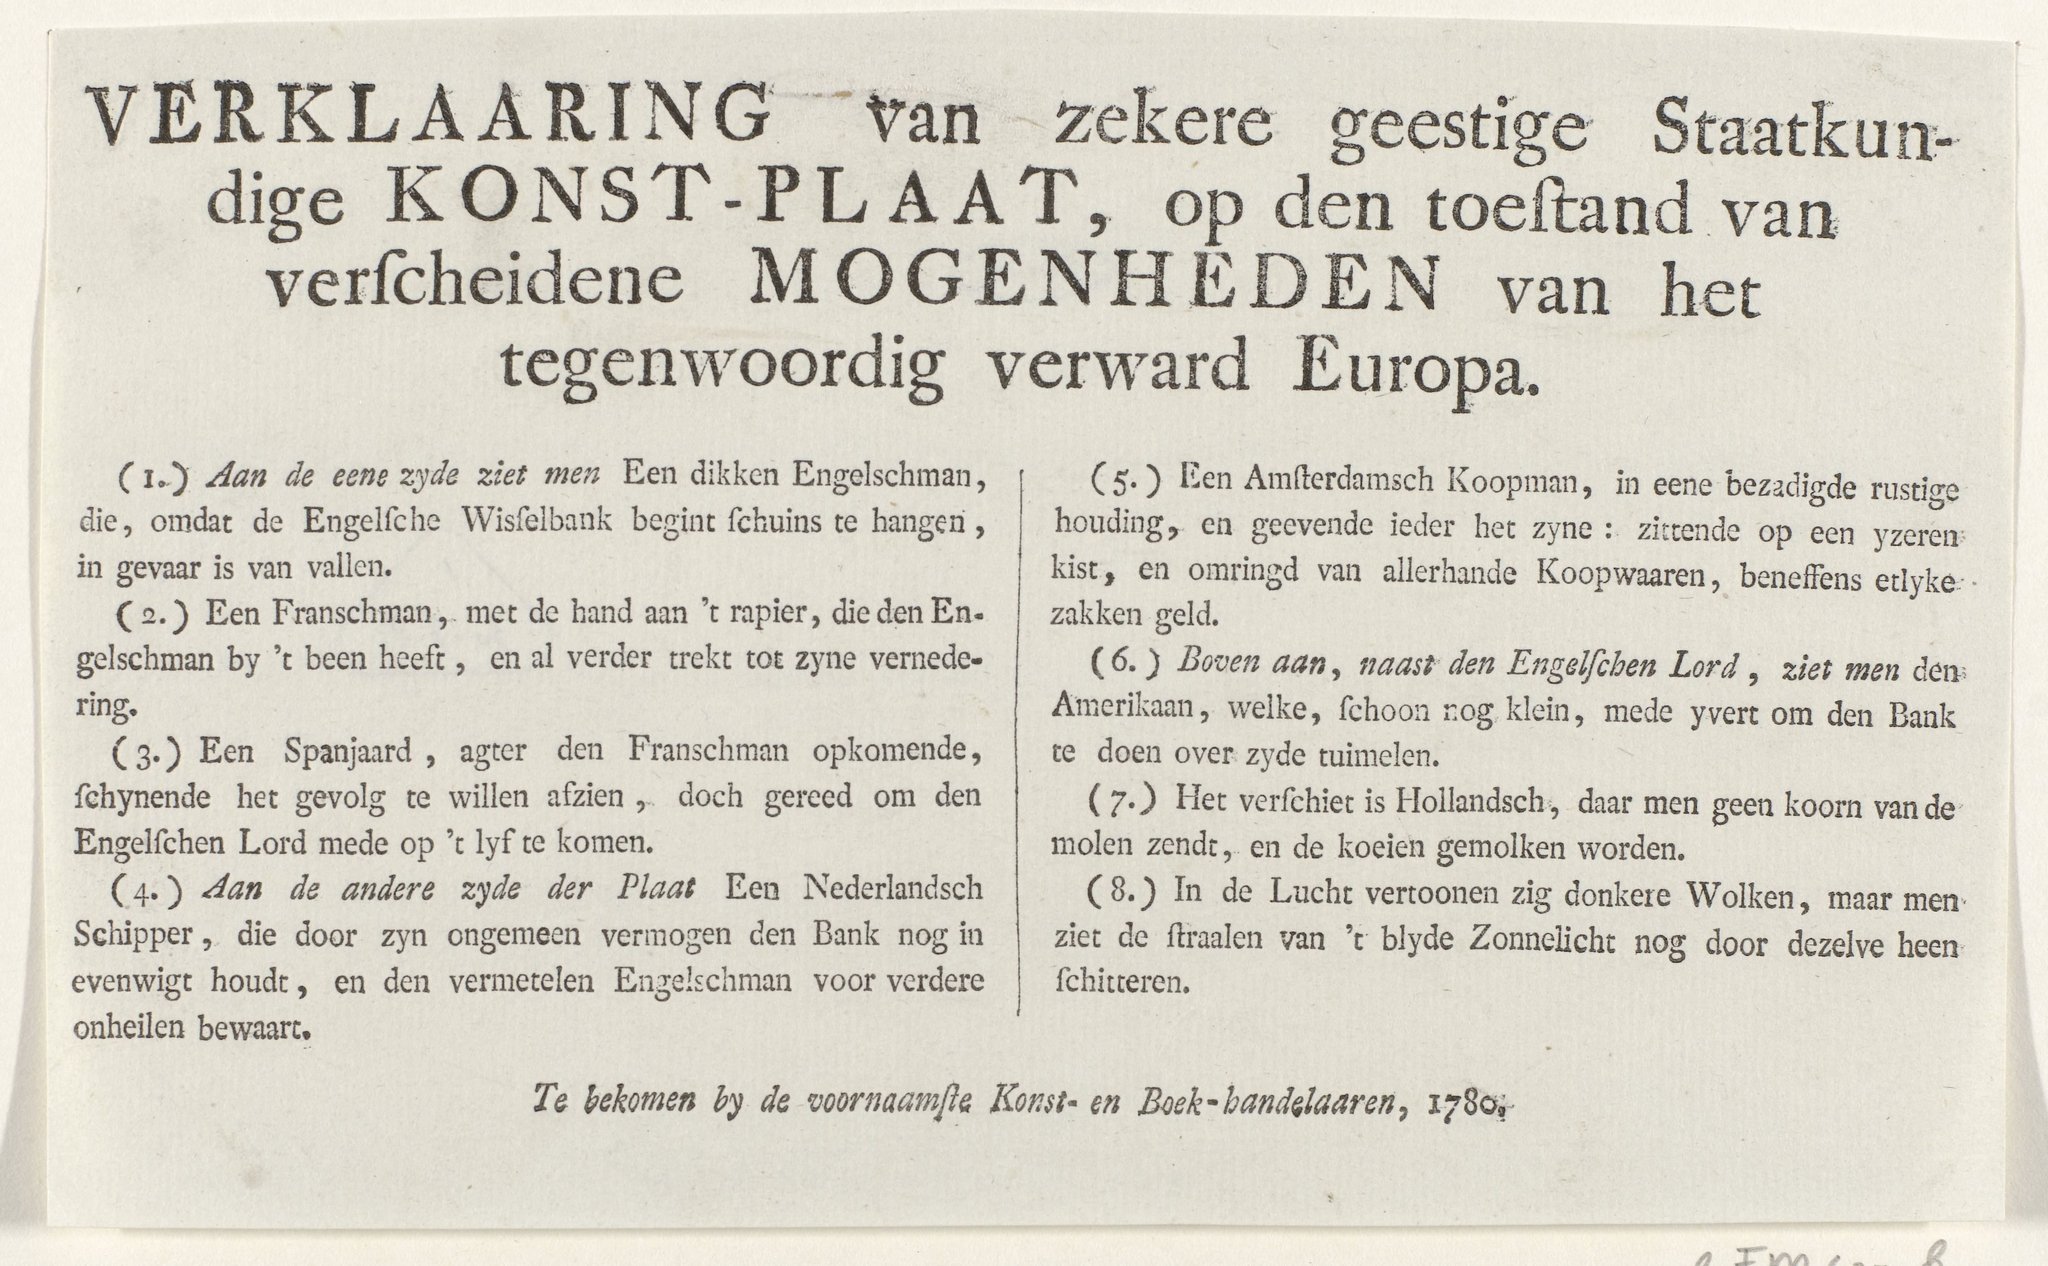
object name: cartoon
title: Verklaaring van zekere geestige Staatkundige Konst-Plaat, op den toestand van verscheidene Mogendheden van het tegenwoordig verward Europa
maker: Anonymous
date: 1780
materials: paper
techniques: letterpress printing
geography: northern netherlands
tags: political caricatures and satires, fourth anglo-dutch war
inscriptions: collector's mark: Lugt 2228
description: Tekstblad met een verklaring van de de cijfers 1-8 in de spotprent op de wankele toestand van de Britse economie in 1780.